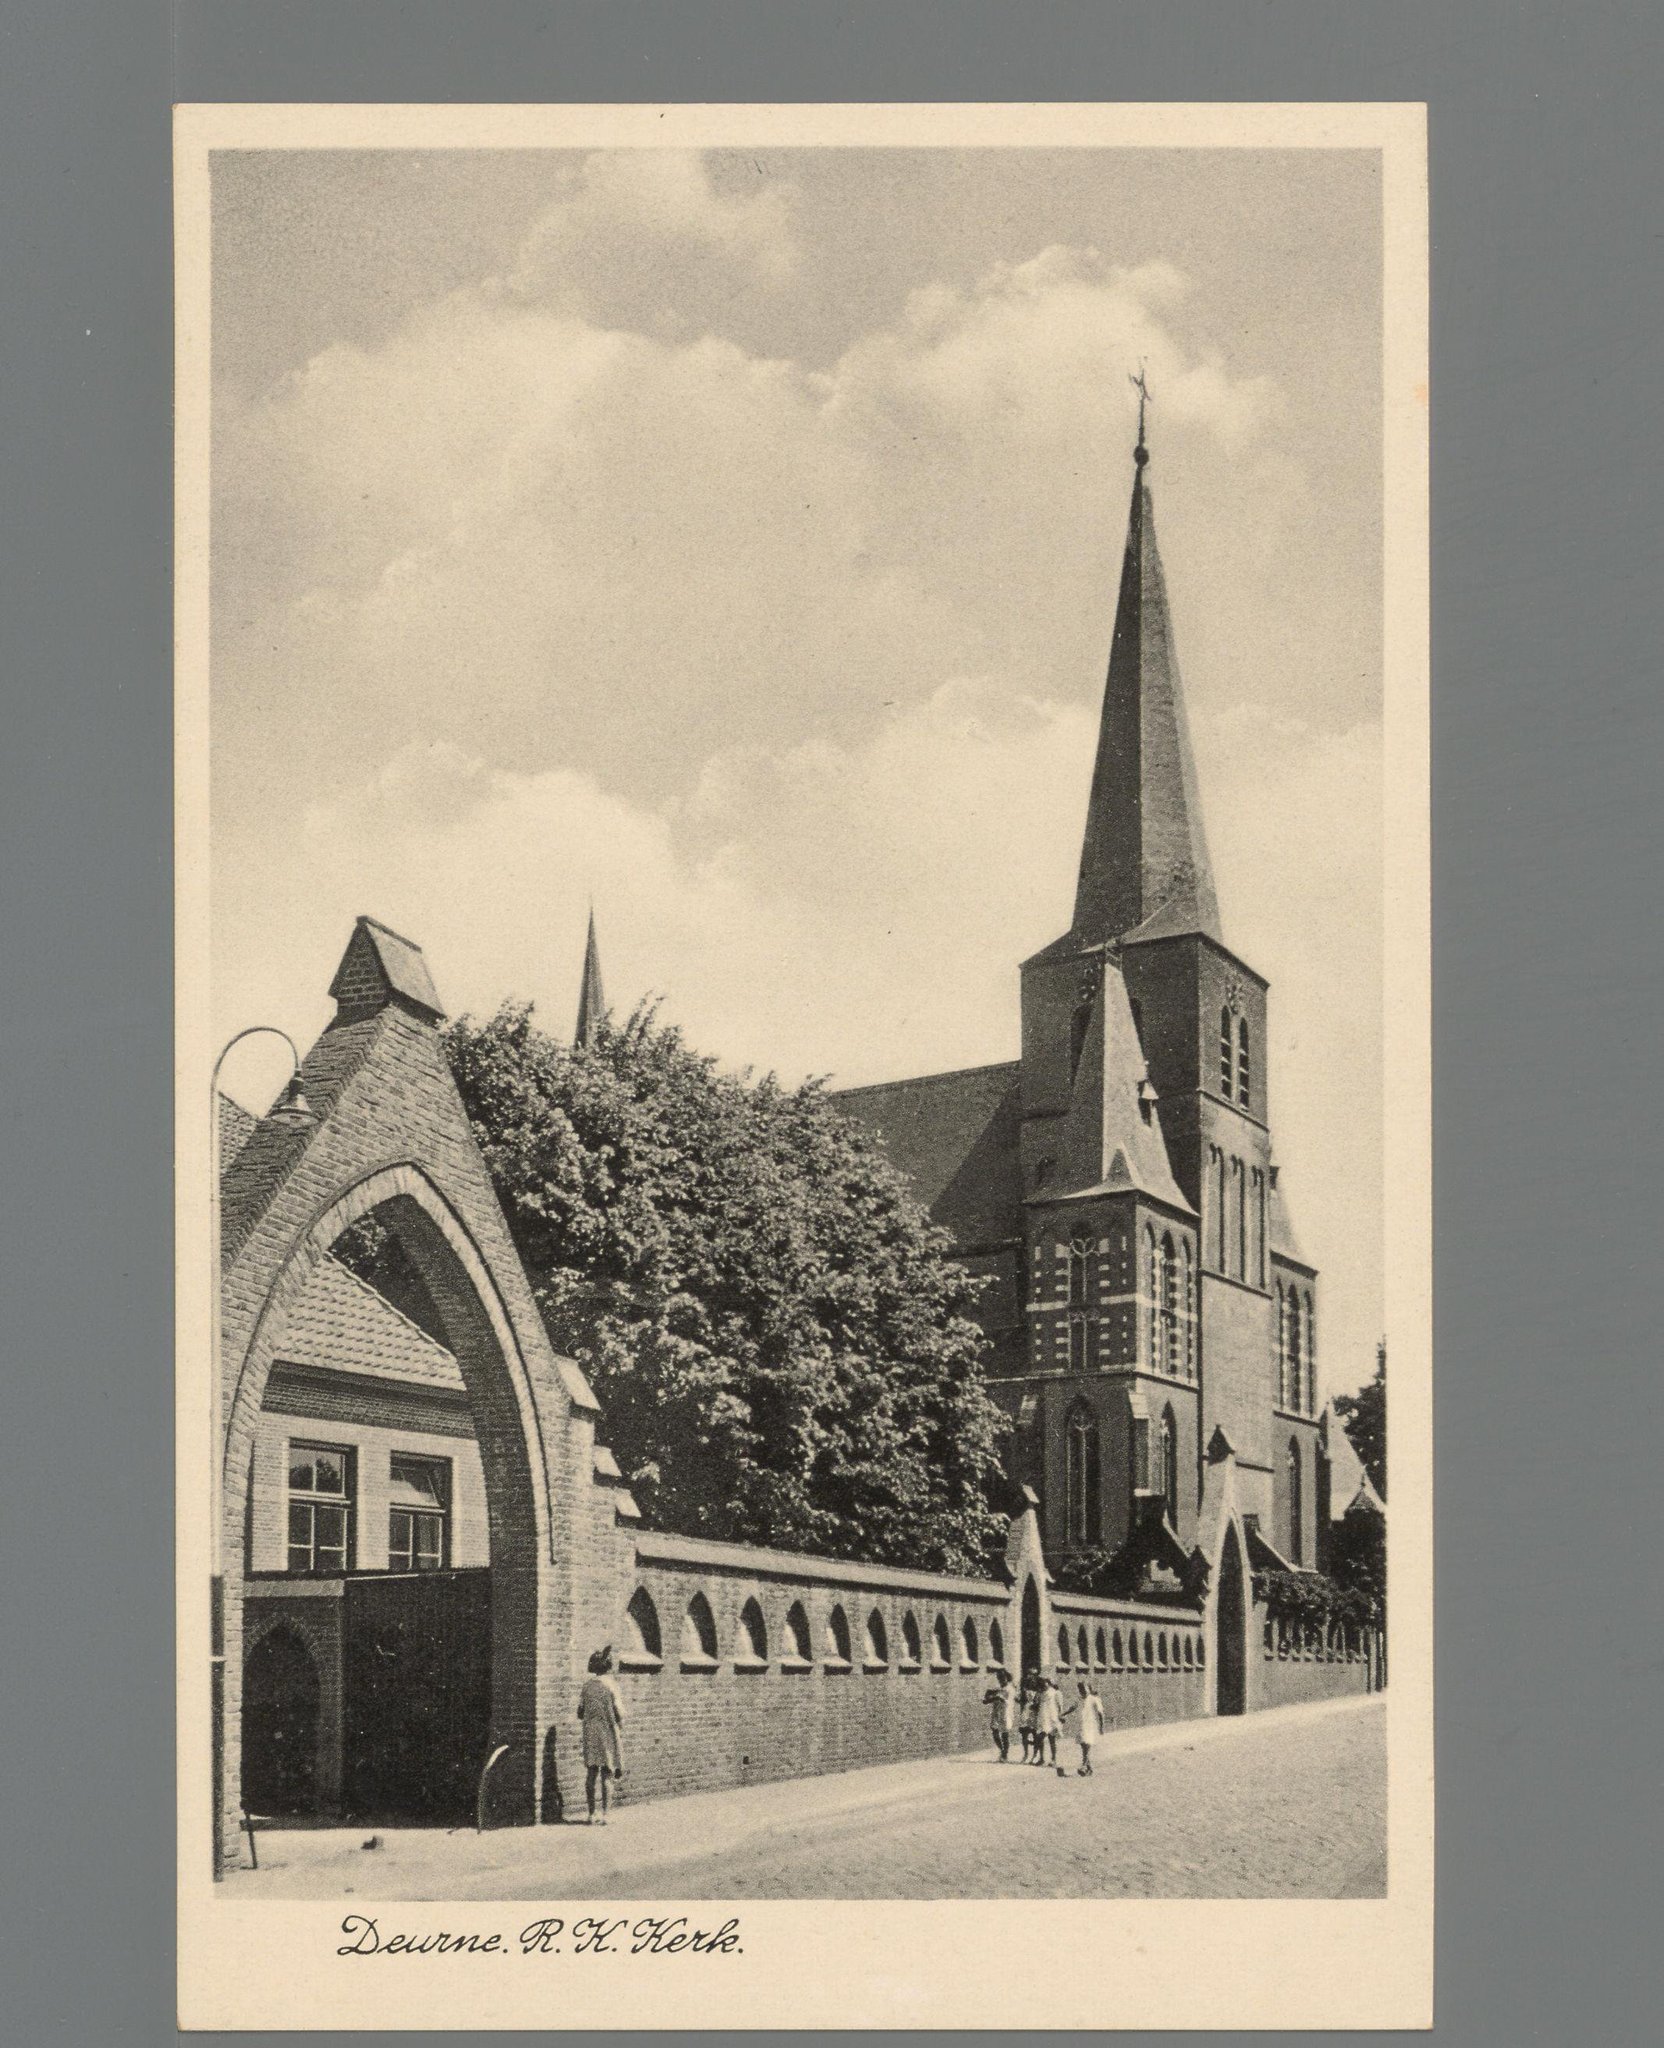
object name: ansichtkaart, prentbriefkaart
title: Deurne. R.K. Kerk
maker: Anonymous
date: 1930-1950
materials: cardboard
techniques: photograph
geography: the hague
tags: church (exterior)